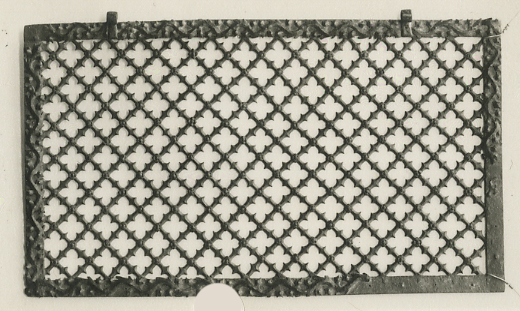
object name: grill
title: Grille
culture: european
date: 1401-1600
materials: iron